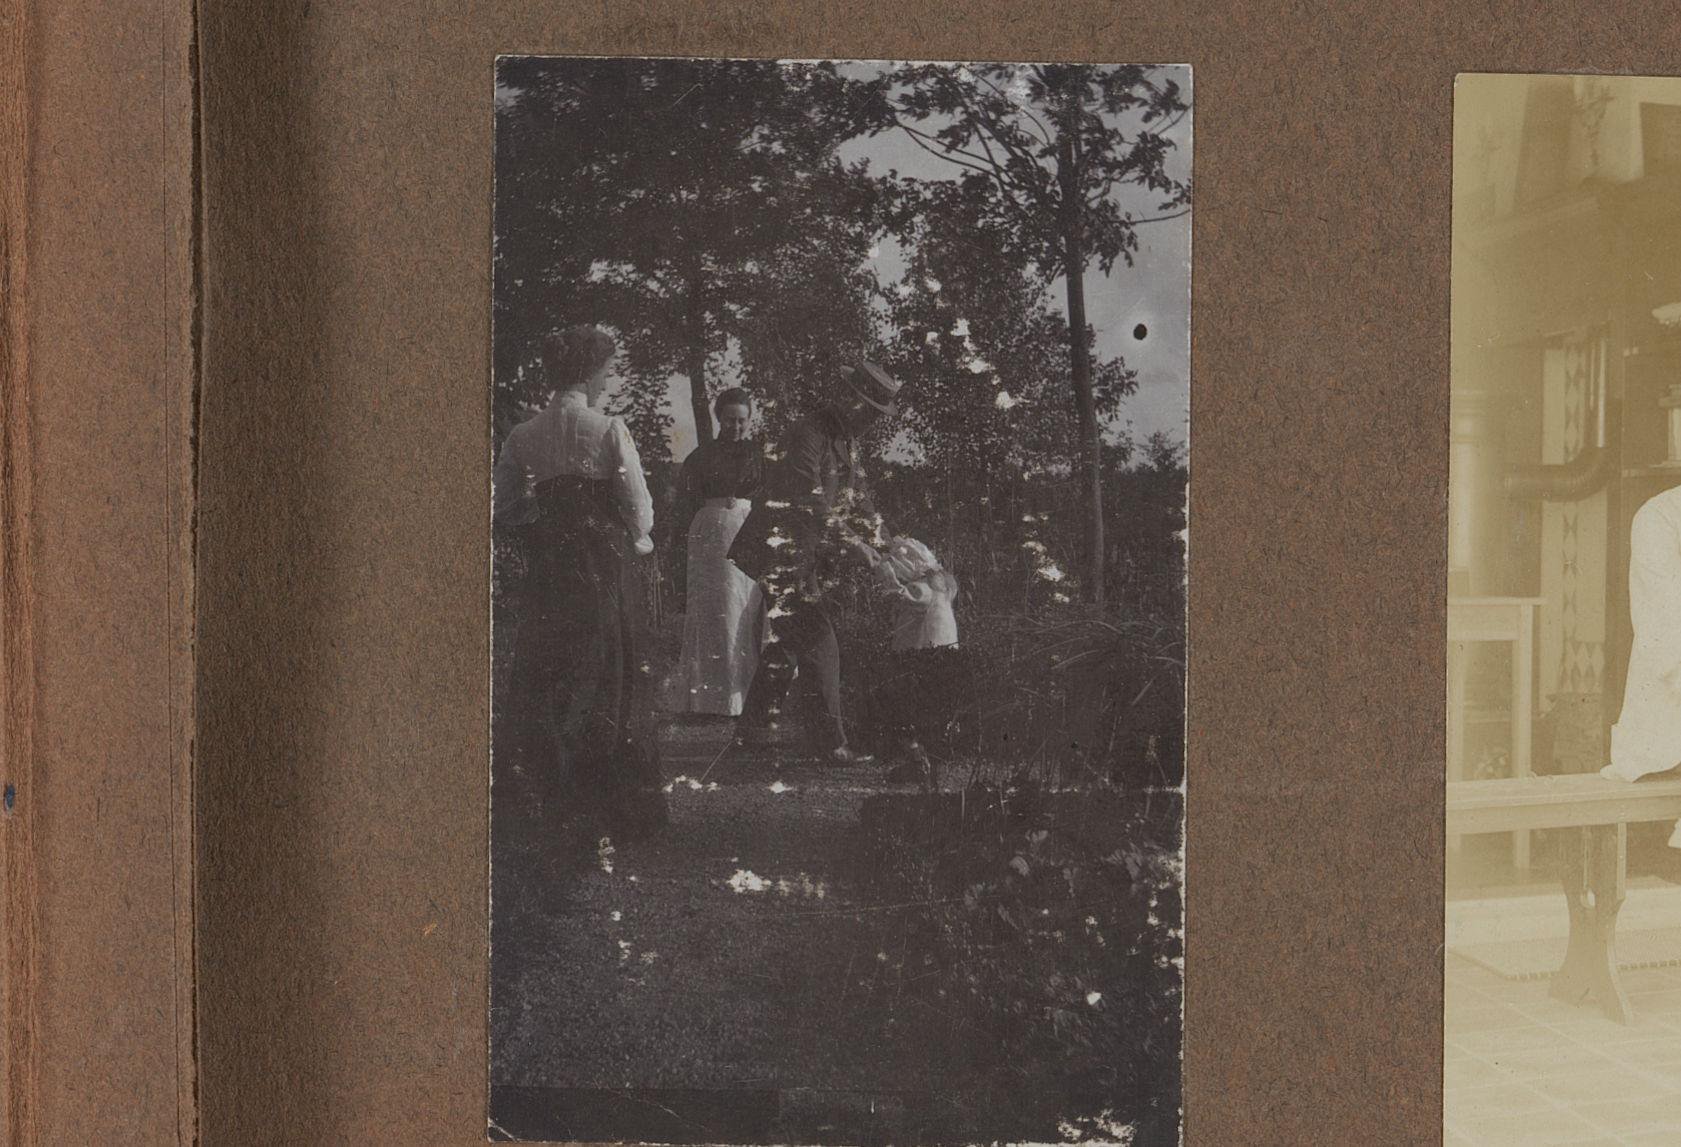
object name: photograph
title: Gezelschap buiten, De Hoeve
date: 1908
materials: photographic support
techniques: photography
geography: amsterdam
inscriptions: date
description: Foto op bruin albumblad 3 van familiealbum van Alphons Diepenbrock.